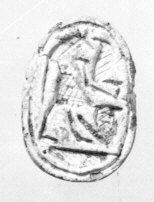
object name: stamp seal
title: Scarab seal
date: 1700-1560 BCE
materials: bone, stone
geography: levant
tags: scarabs